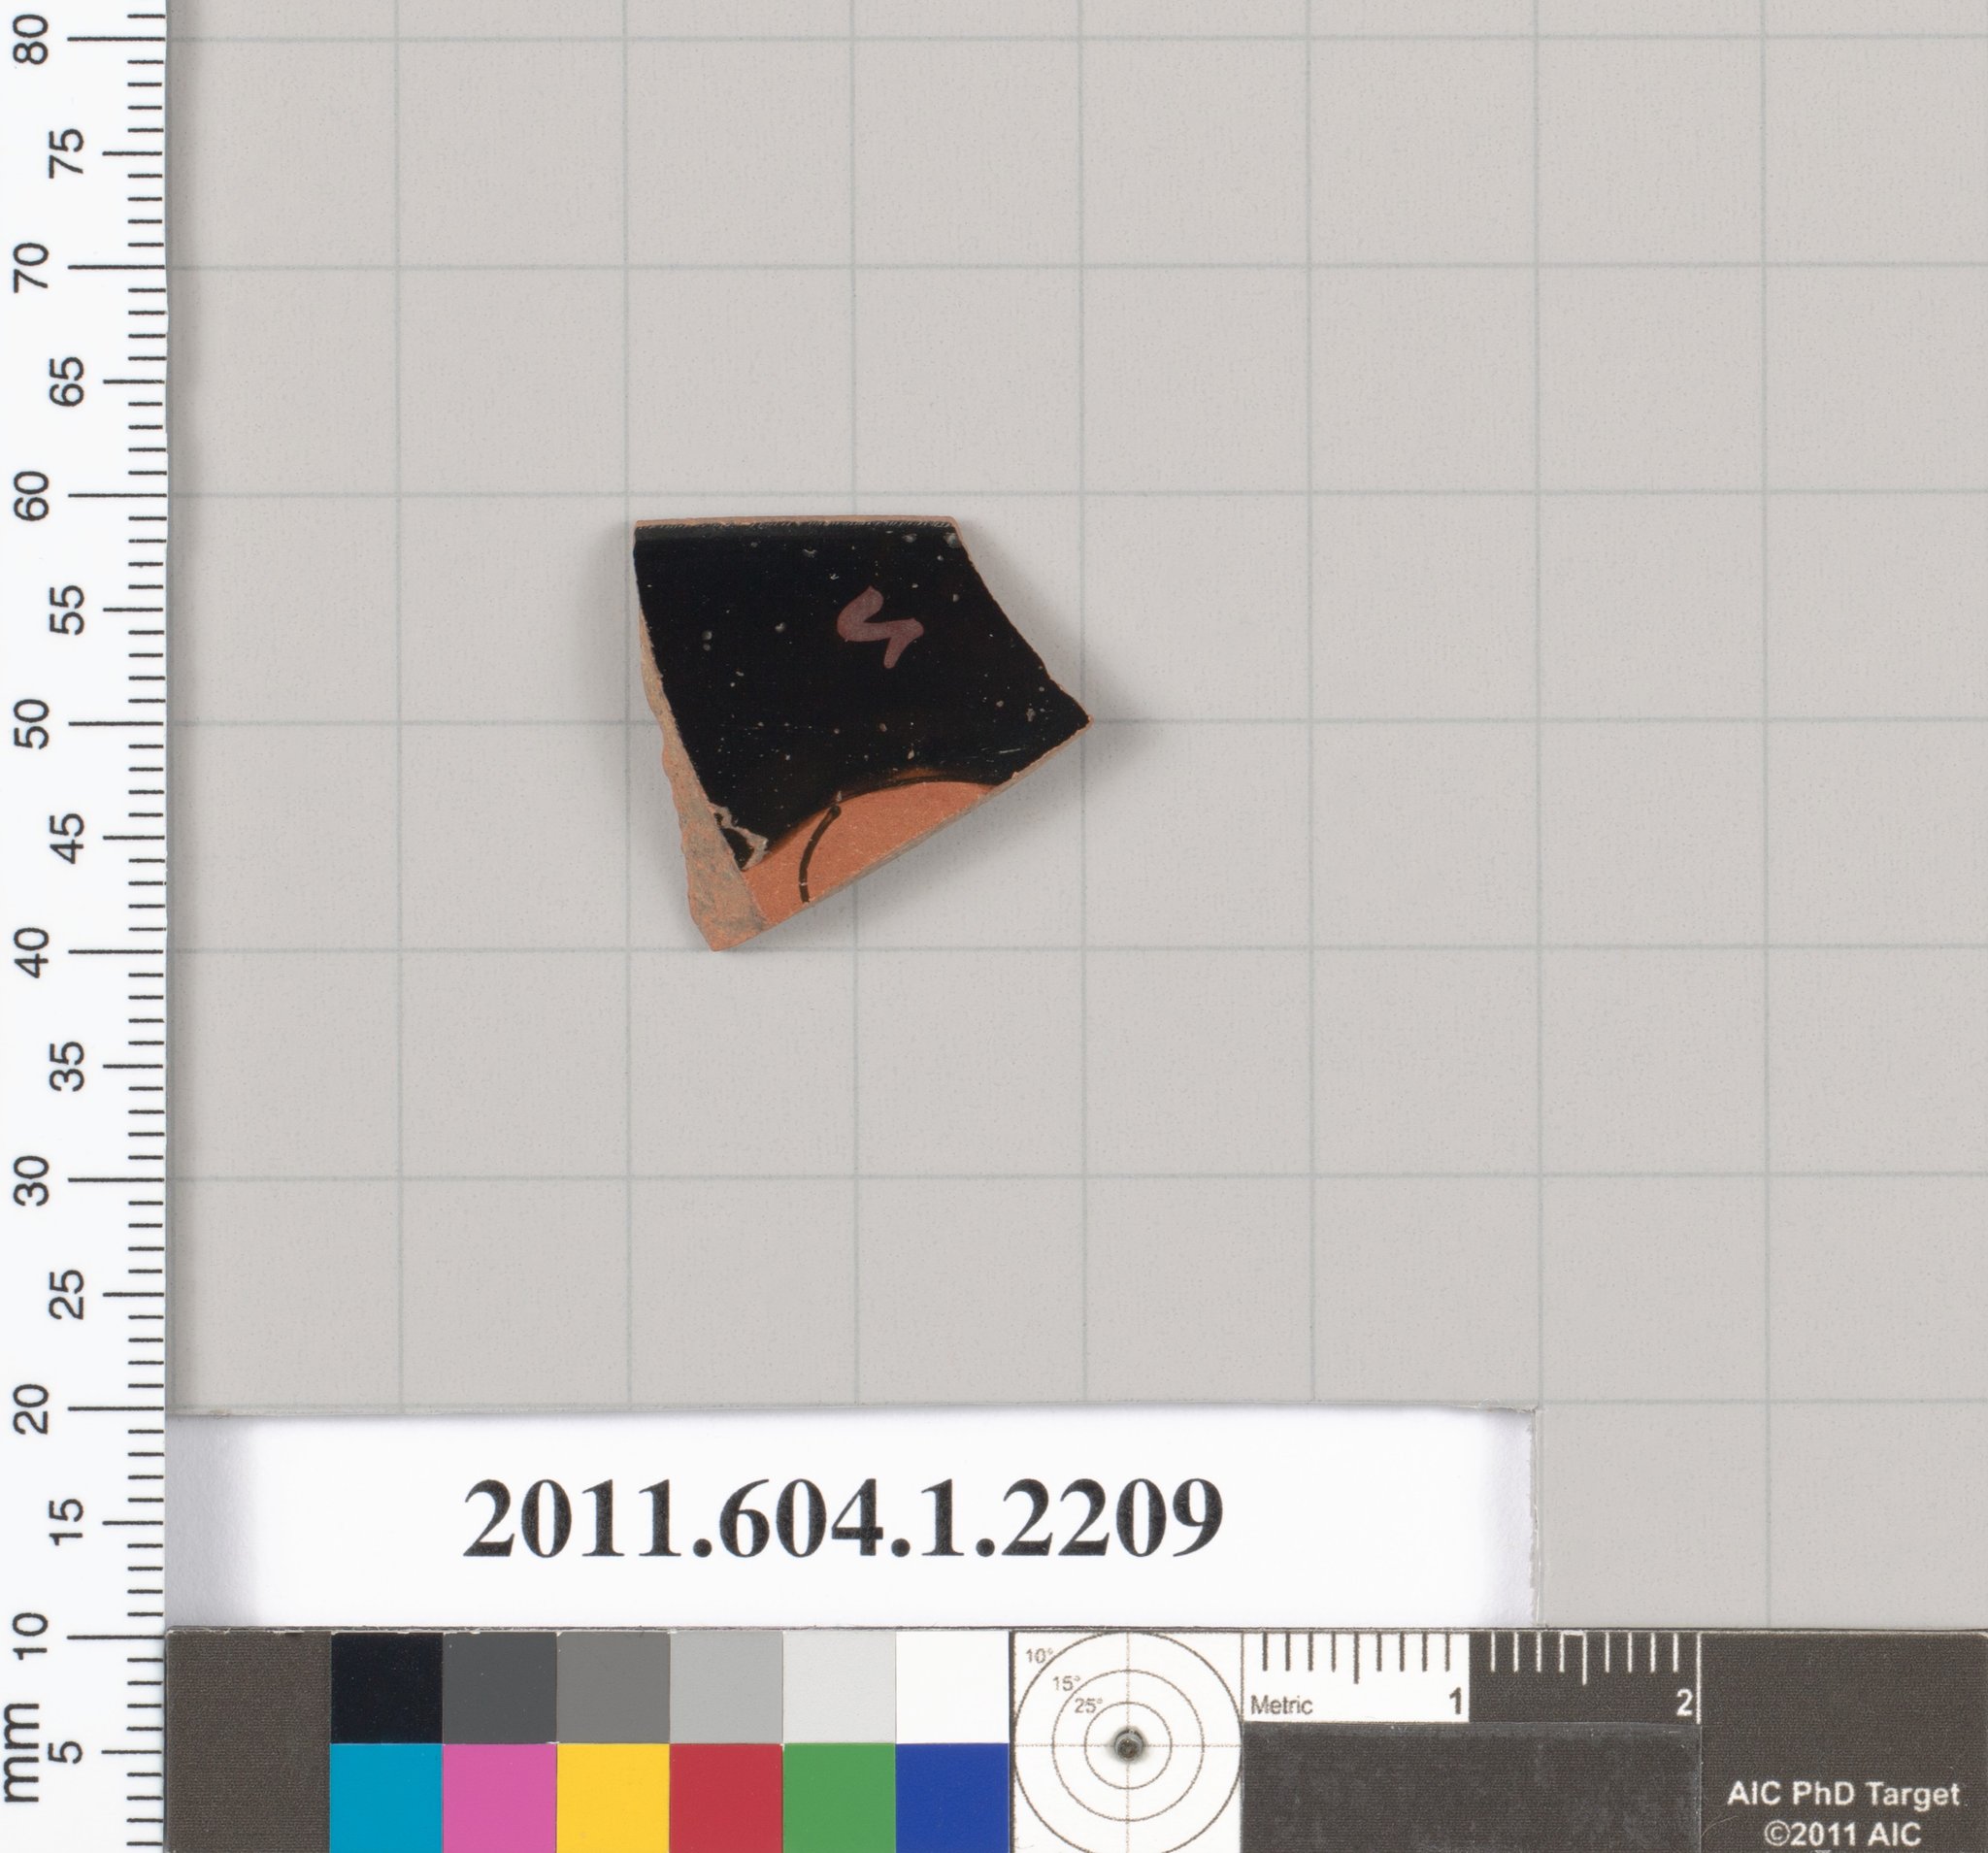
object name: kylix fragment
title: Terracotta rim fragment of a kylix (drinking cup)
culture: greek, attic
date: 500-451 BCE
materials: terracotta